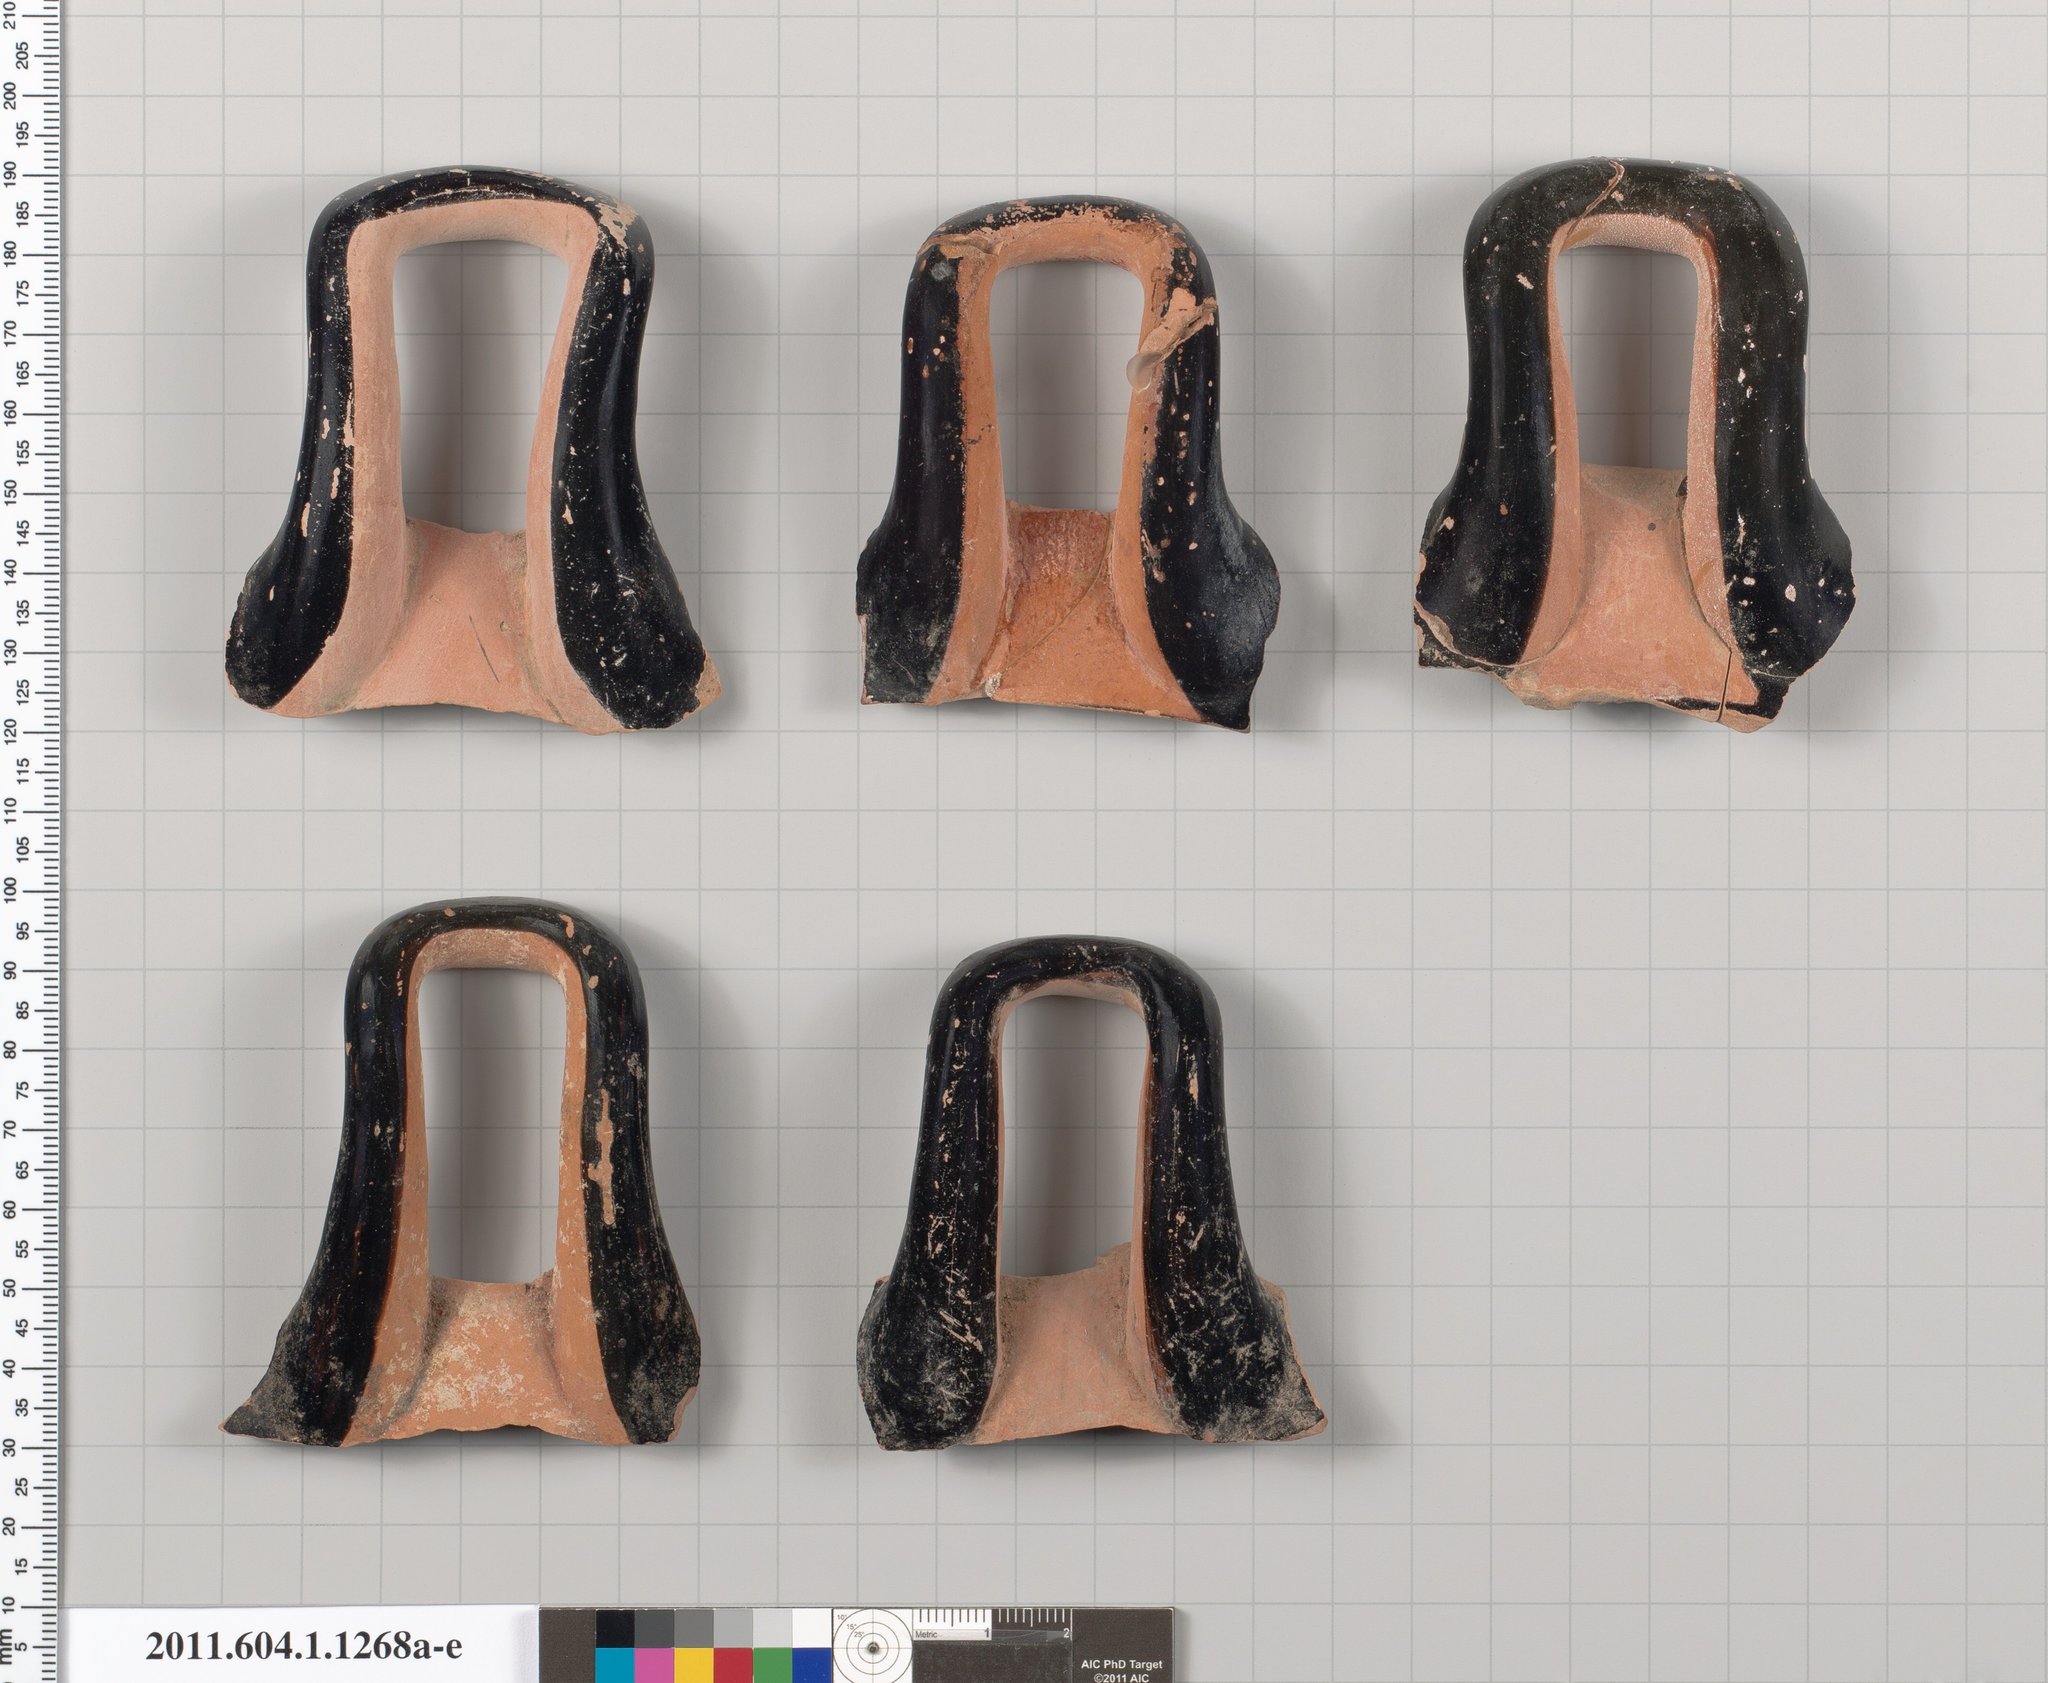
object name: kylix fragment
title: Terracotta fragments of kylikes (drinking cups)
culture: greek, attic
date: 500-401 BCE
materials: terracotta